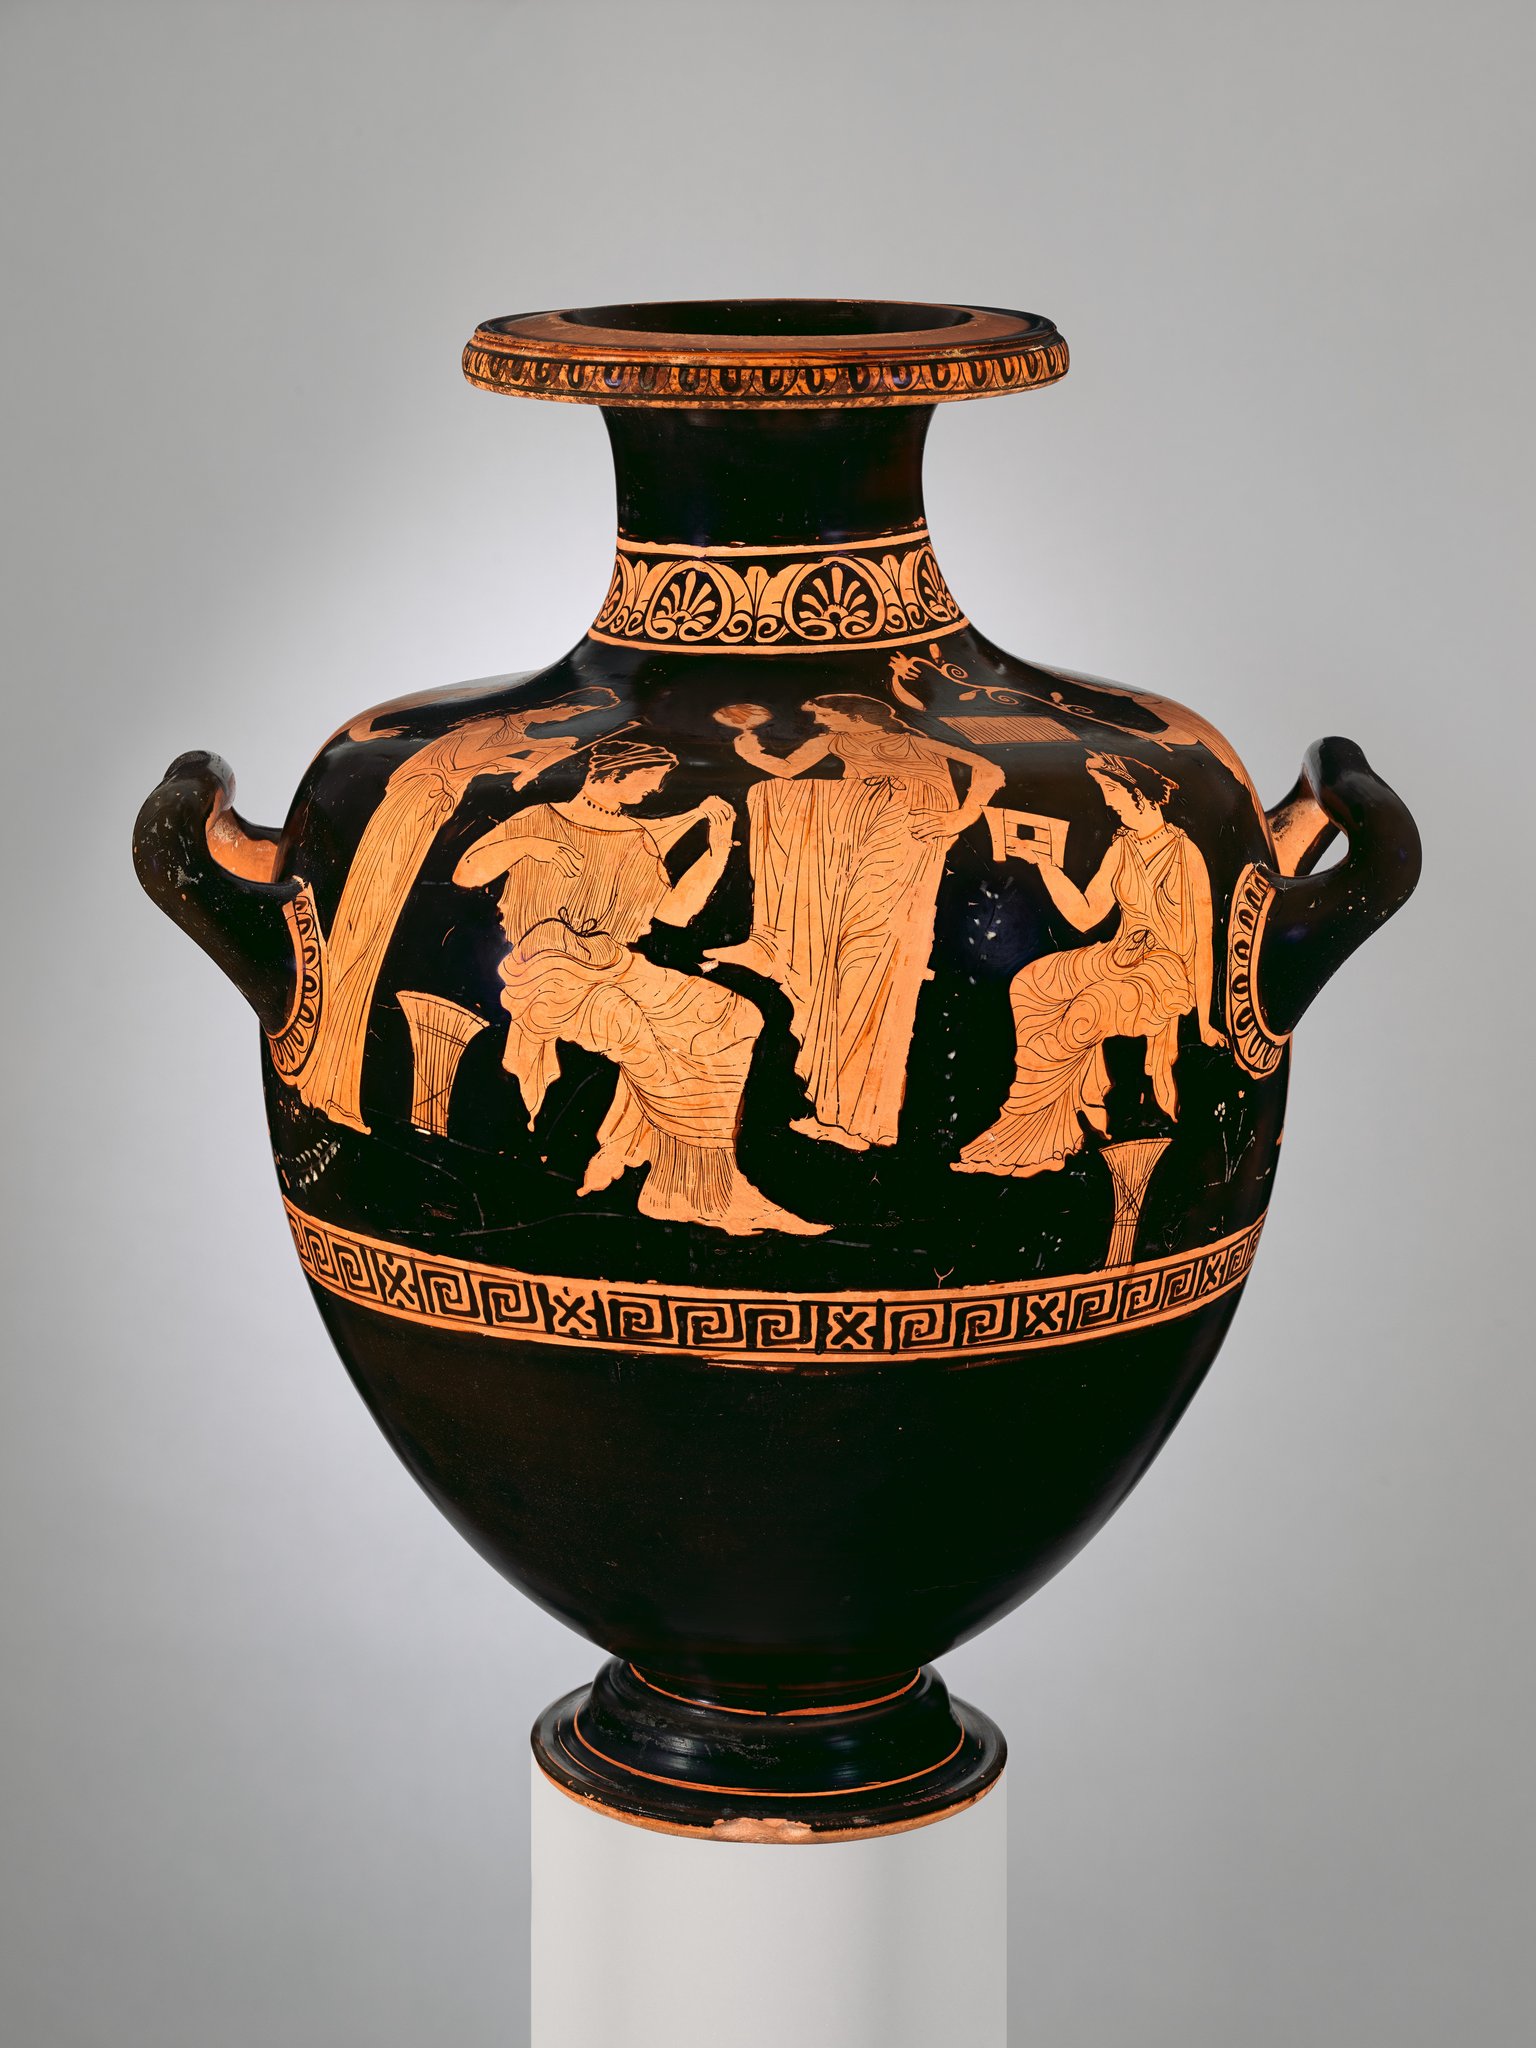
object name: hydria, kalpis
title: Terracotta hydria: kalpis (water jar)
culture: greek, attic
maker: chrysis painter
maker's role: artist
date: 420-410 BCE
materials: terracotta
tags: women